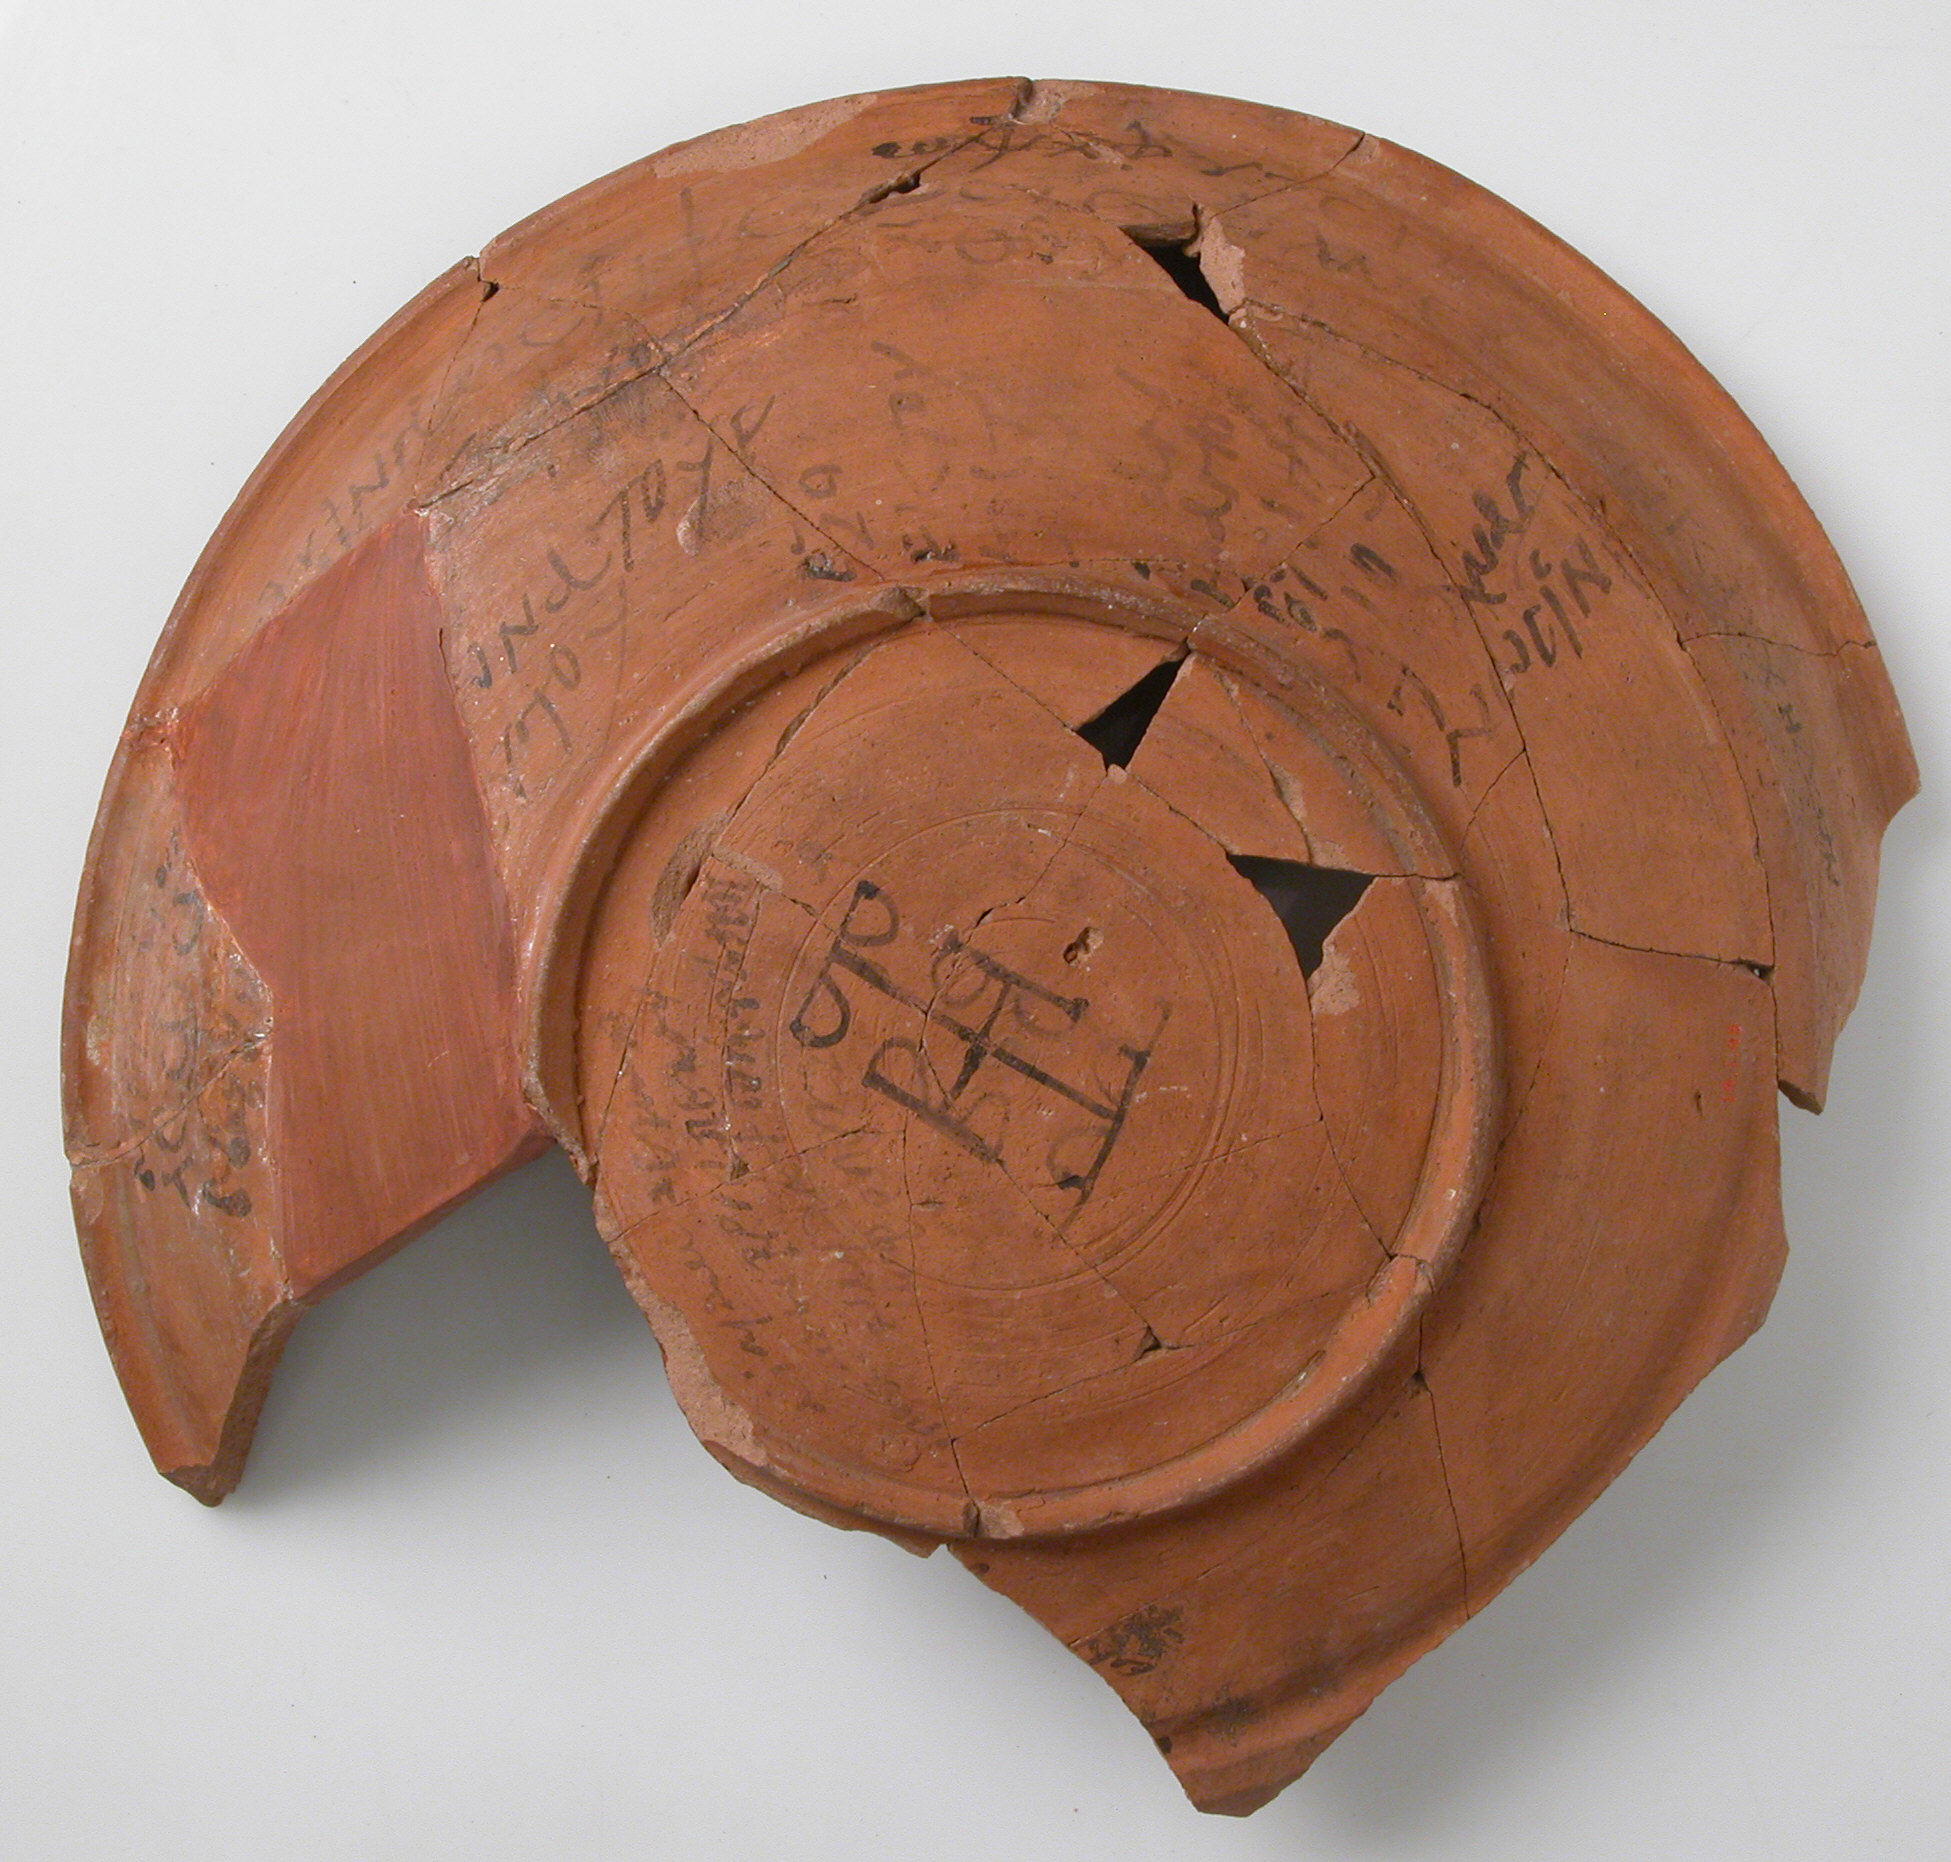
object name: ostrakon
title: Ostrakon with Biblical Text and Liturgical Rubric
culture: coptic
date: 600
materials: ink, pottery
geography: egypt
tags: coptic,greek